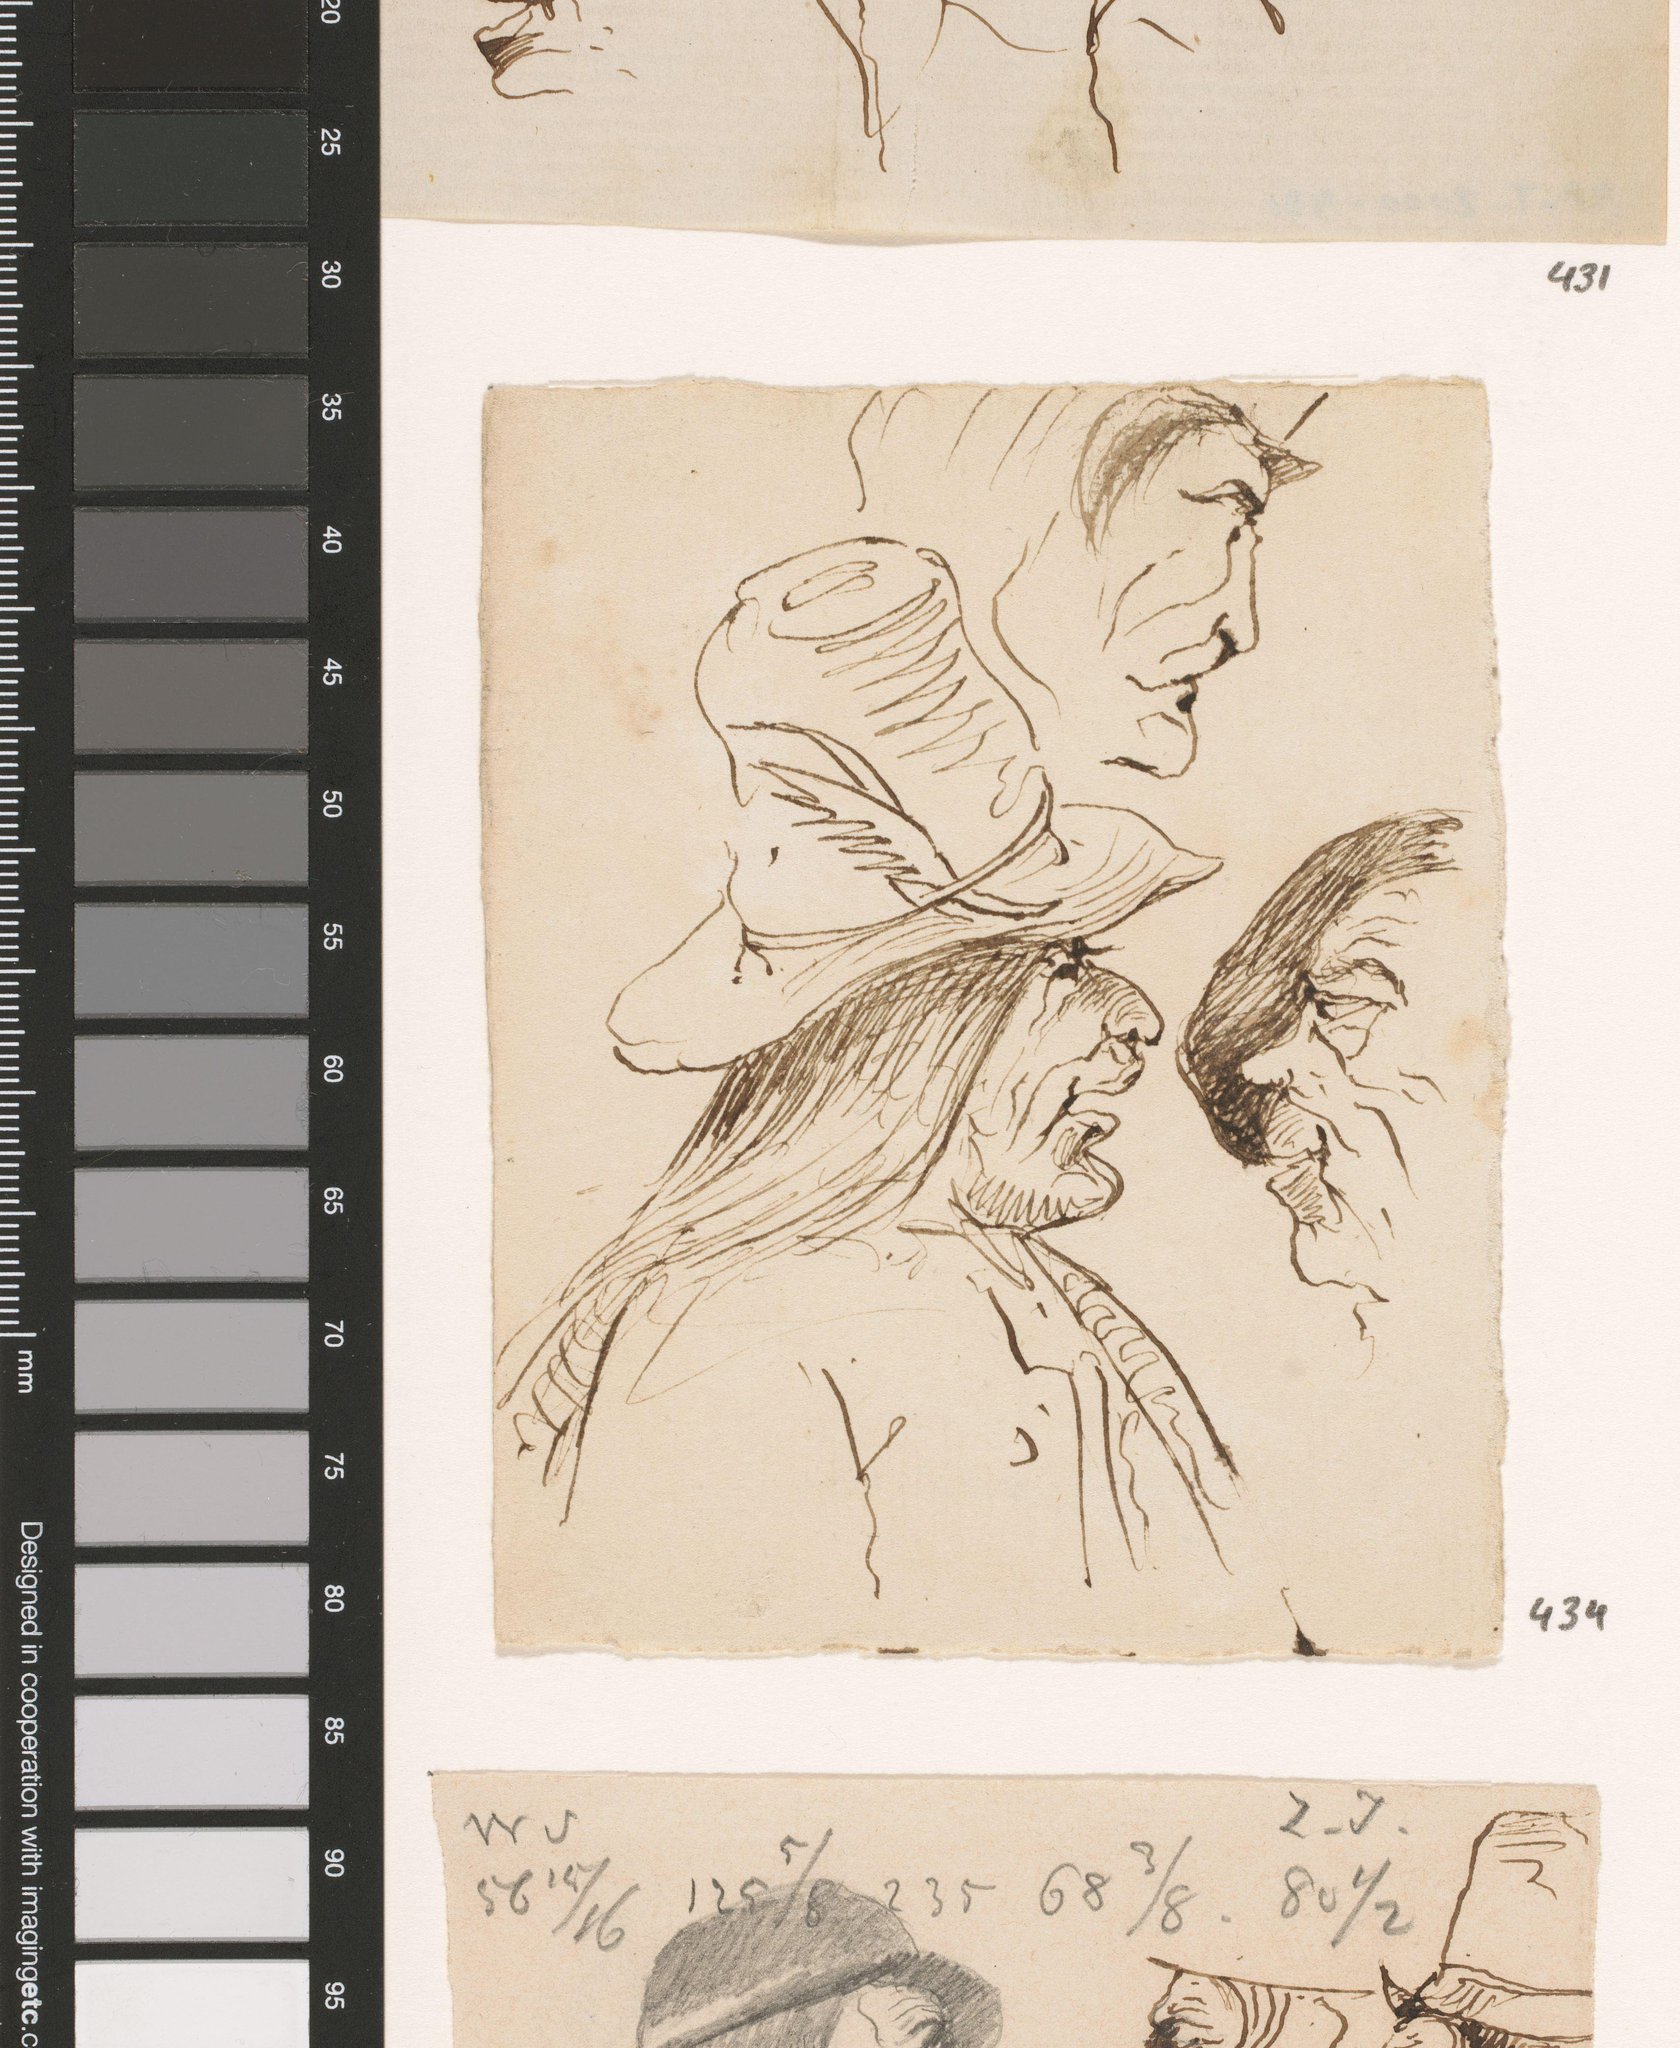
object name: drawing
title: Drie koppen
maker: johannes tavenraat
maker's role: draughtsman, painter, print maker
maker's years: 1809-1881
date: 1840-1880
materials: ink, paper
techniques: pen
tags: caricatures (human types)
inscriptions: collector's mark: Lugt 2228